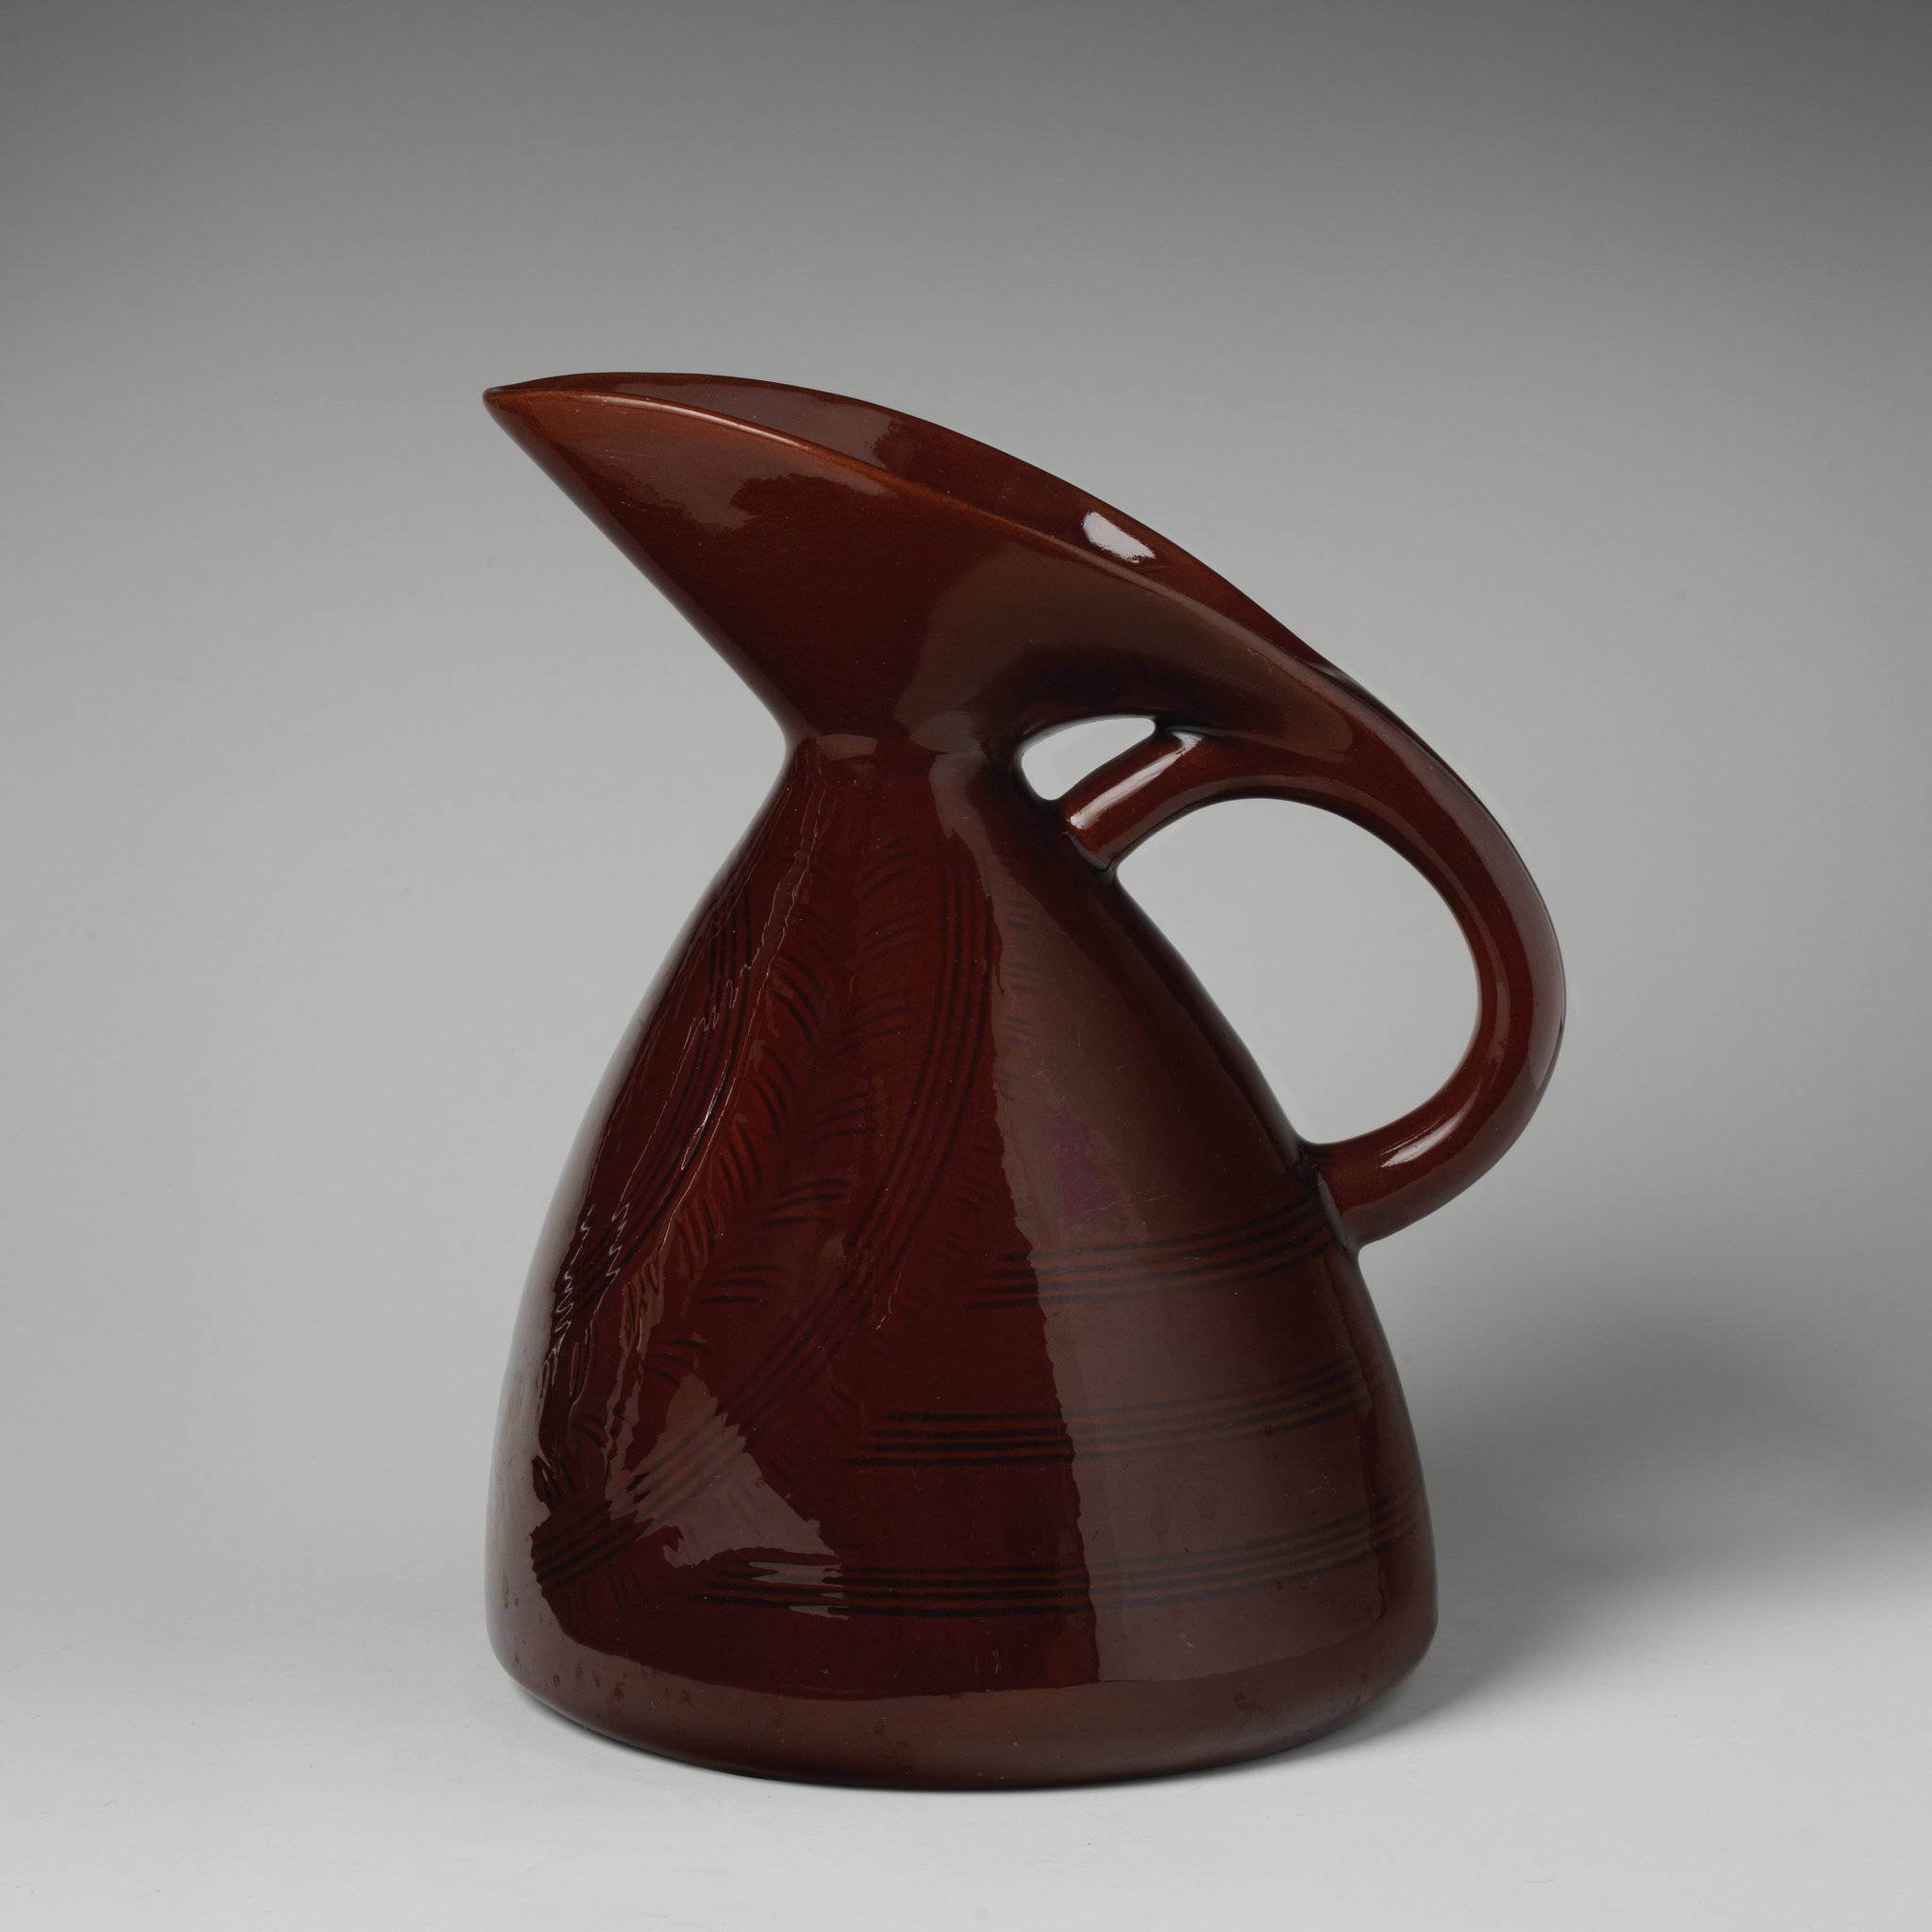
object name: pitcher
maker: christopher dresser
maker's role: maker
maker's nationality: british, scottish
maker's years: 1834-1904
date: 1879-1882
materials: earthenware